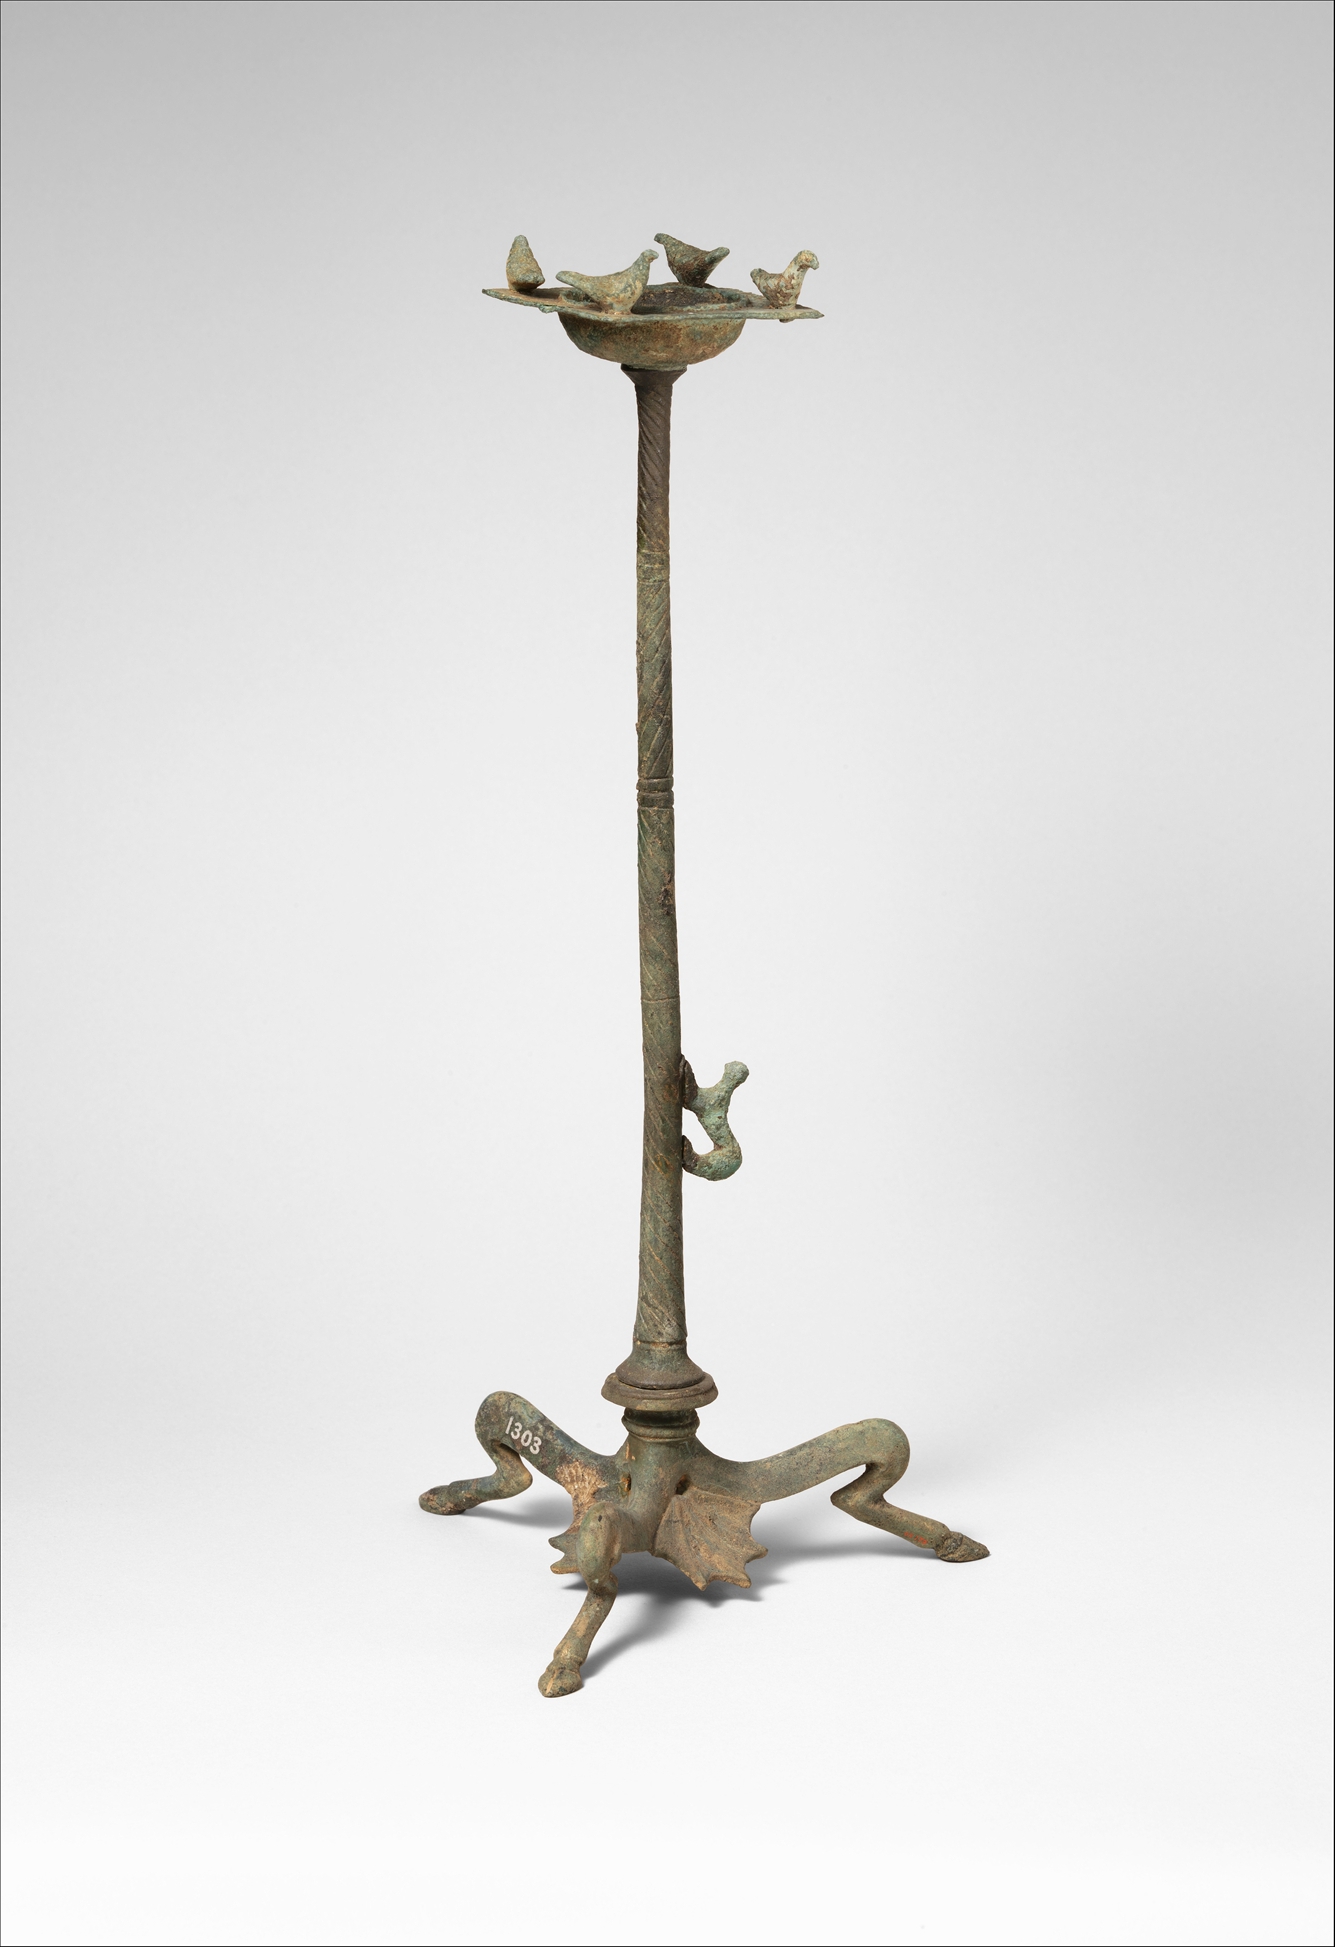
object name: thymiaterion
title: Bronze thymiaterion (incense burner)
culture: etruscan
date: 325-275 BCE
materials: bronze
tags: birds